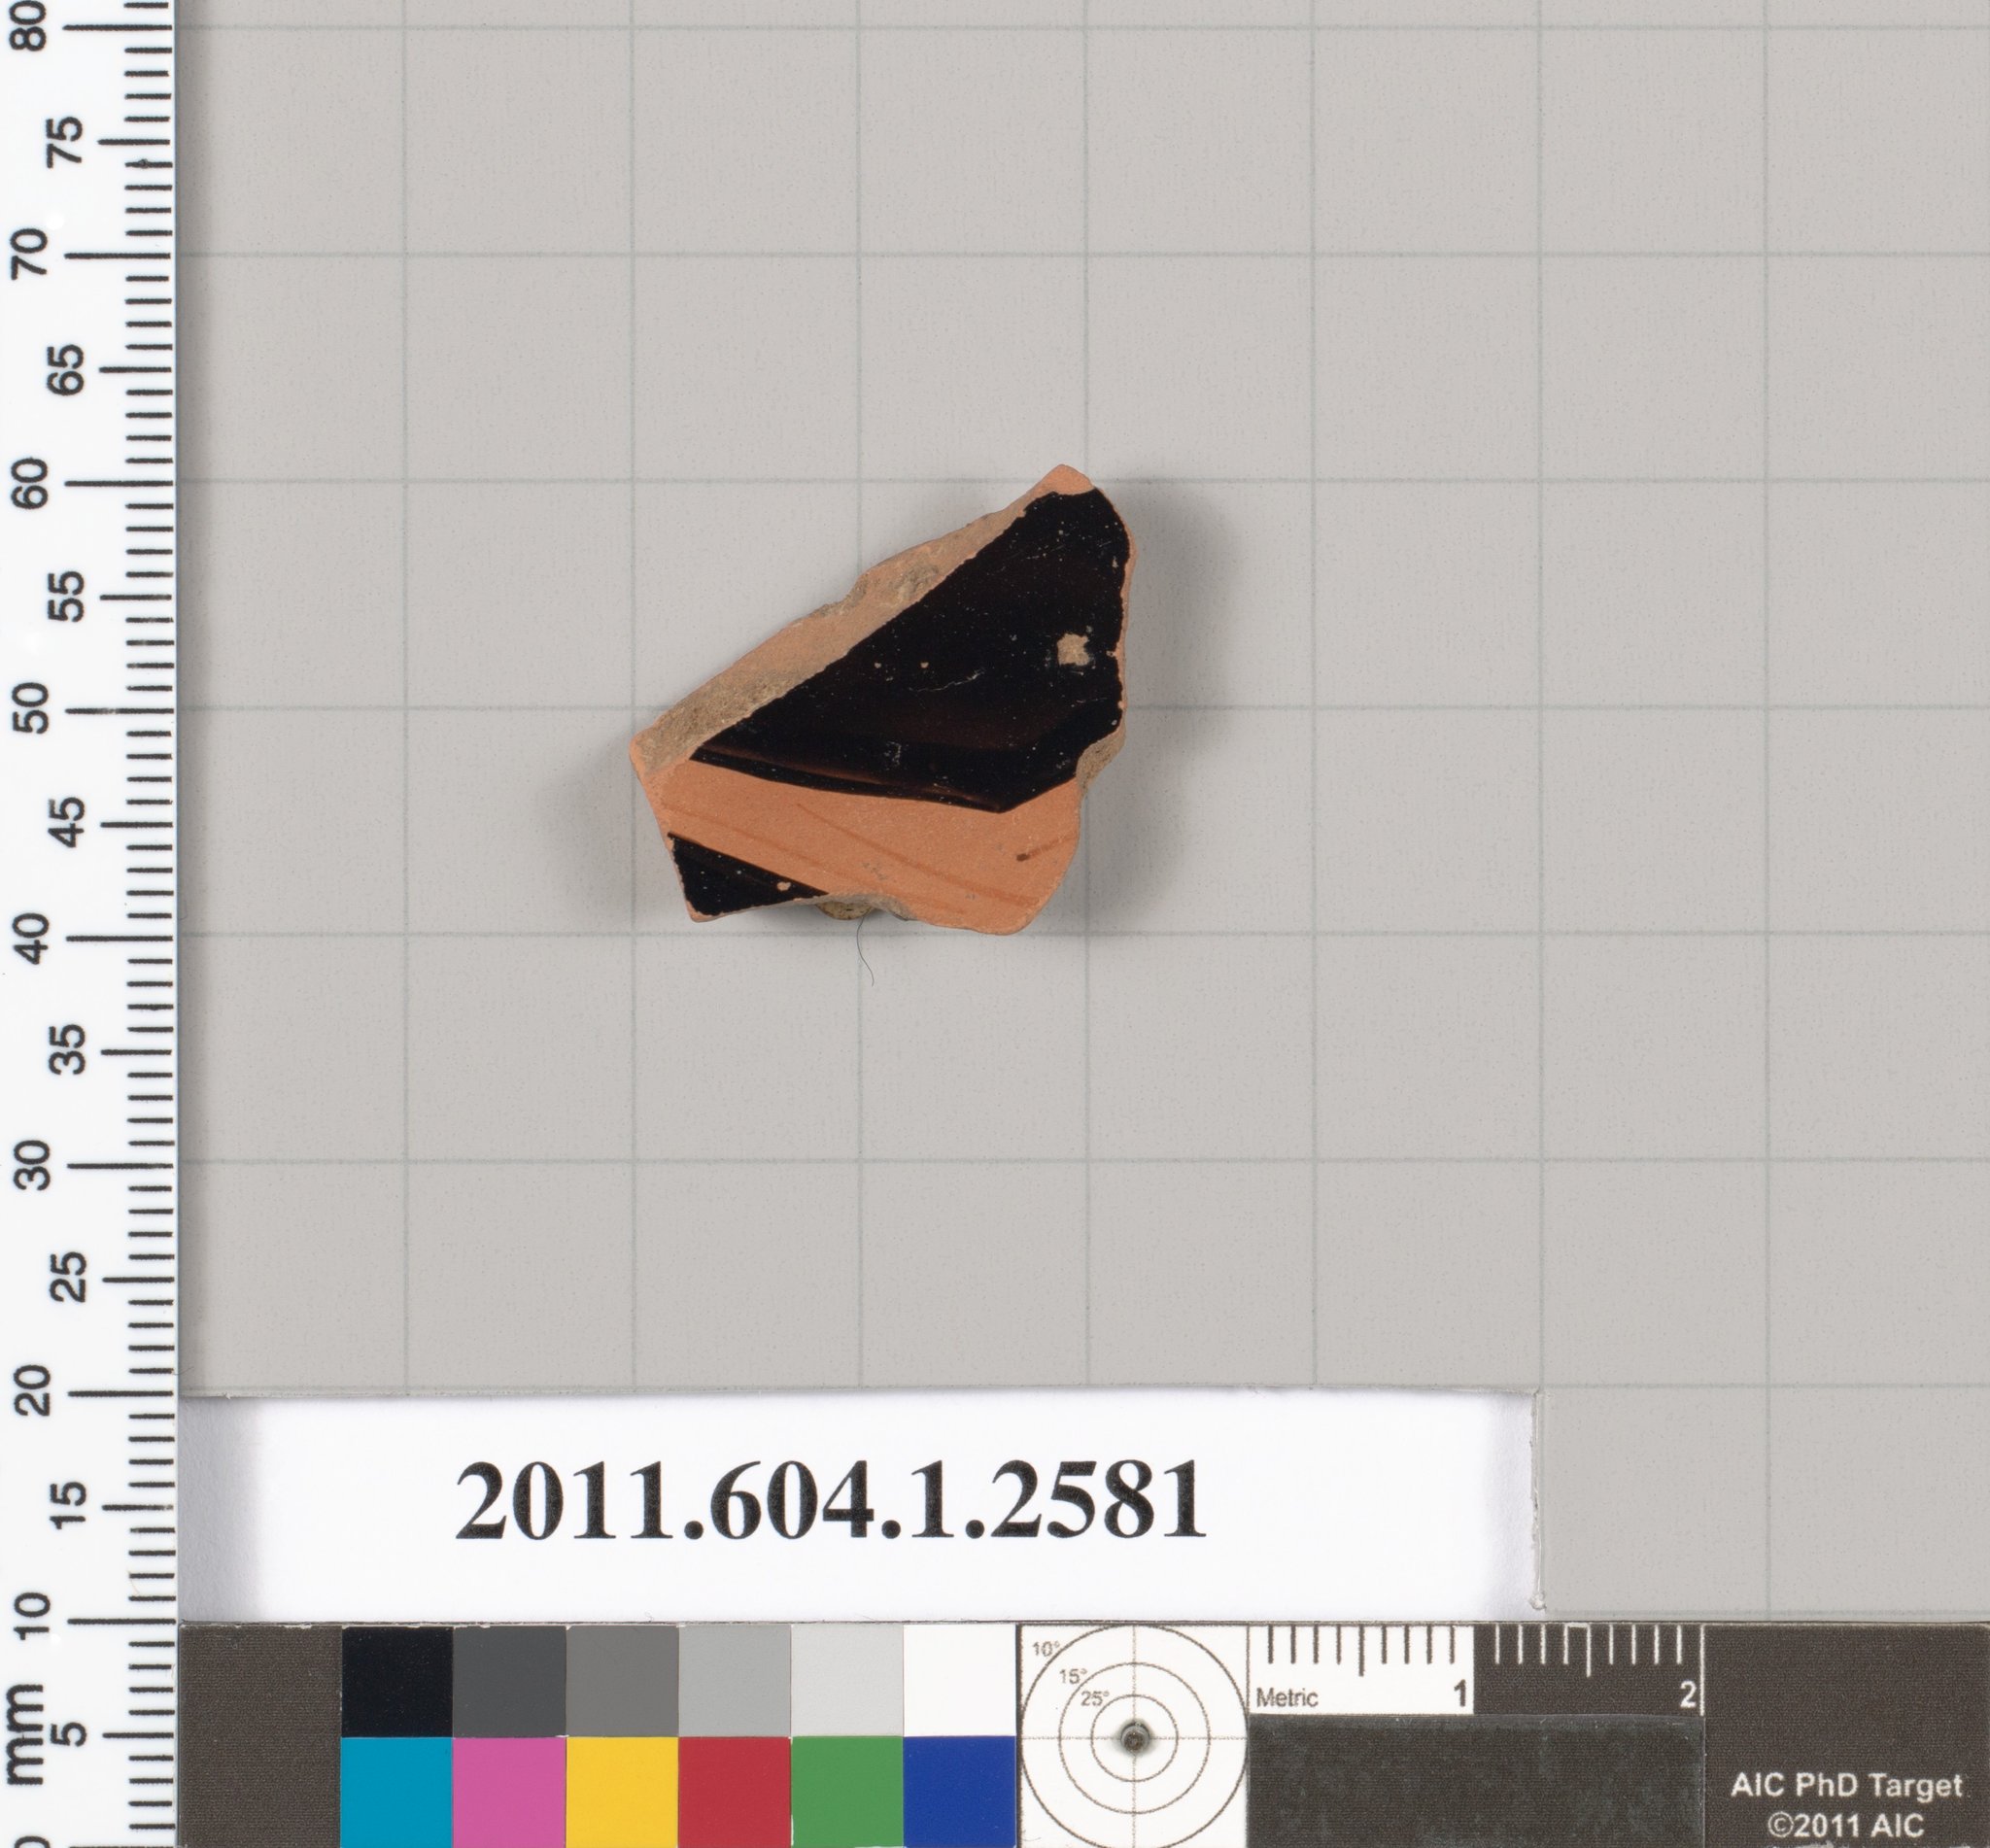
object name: kylix fragment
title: Terracotta fragment of a kylix (drinking cup)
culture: greek, attic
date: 500-451 BCE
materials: terracotta